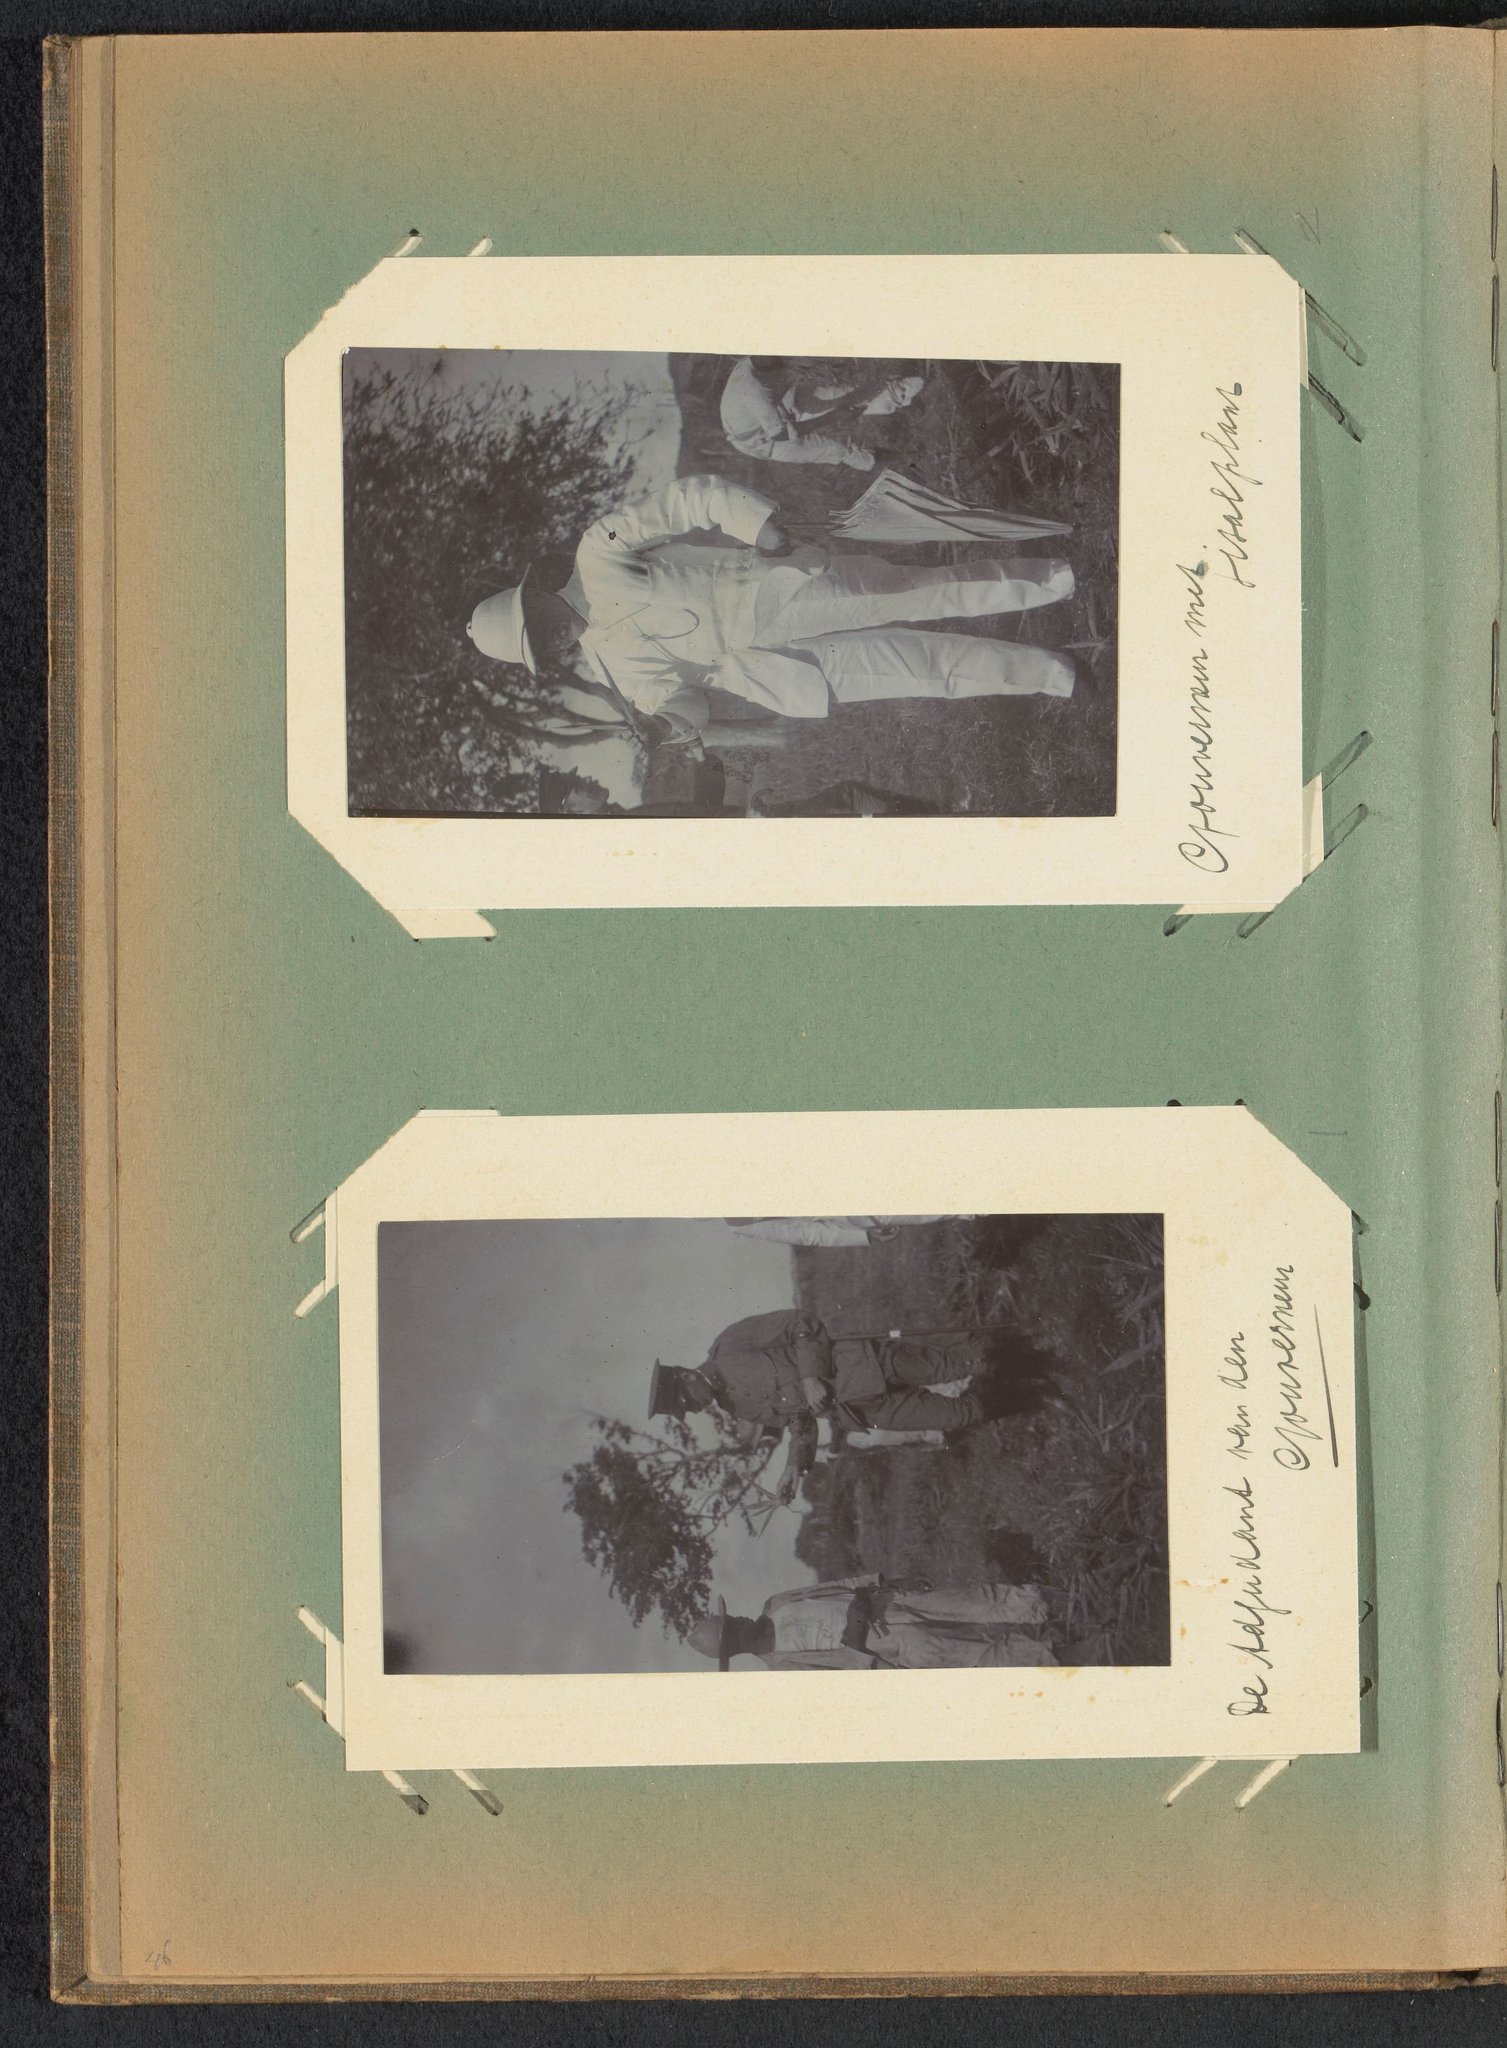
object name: photograph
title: Adjudant van de gouverneur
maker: Anonymous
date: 1912-1913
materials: paper, photographic support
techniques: gelatin silver print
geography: curacao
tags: plantation, (non-fruit) products of plants or trees: sisal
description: De adjudant van de gouverneur, tijdens het bezoek van de gouverneur aan de sisalvelden op Plantage Mount Pleasant op Curaçao. Onderdeel van het fotoalbum uit ca. 1912-1913 met 92 foto's van de plantages Peperpot en Dordrecht in Suriname en Mount Pleasant op Curaçao.